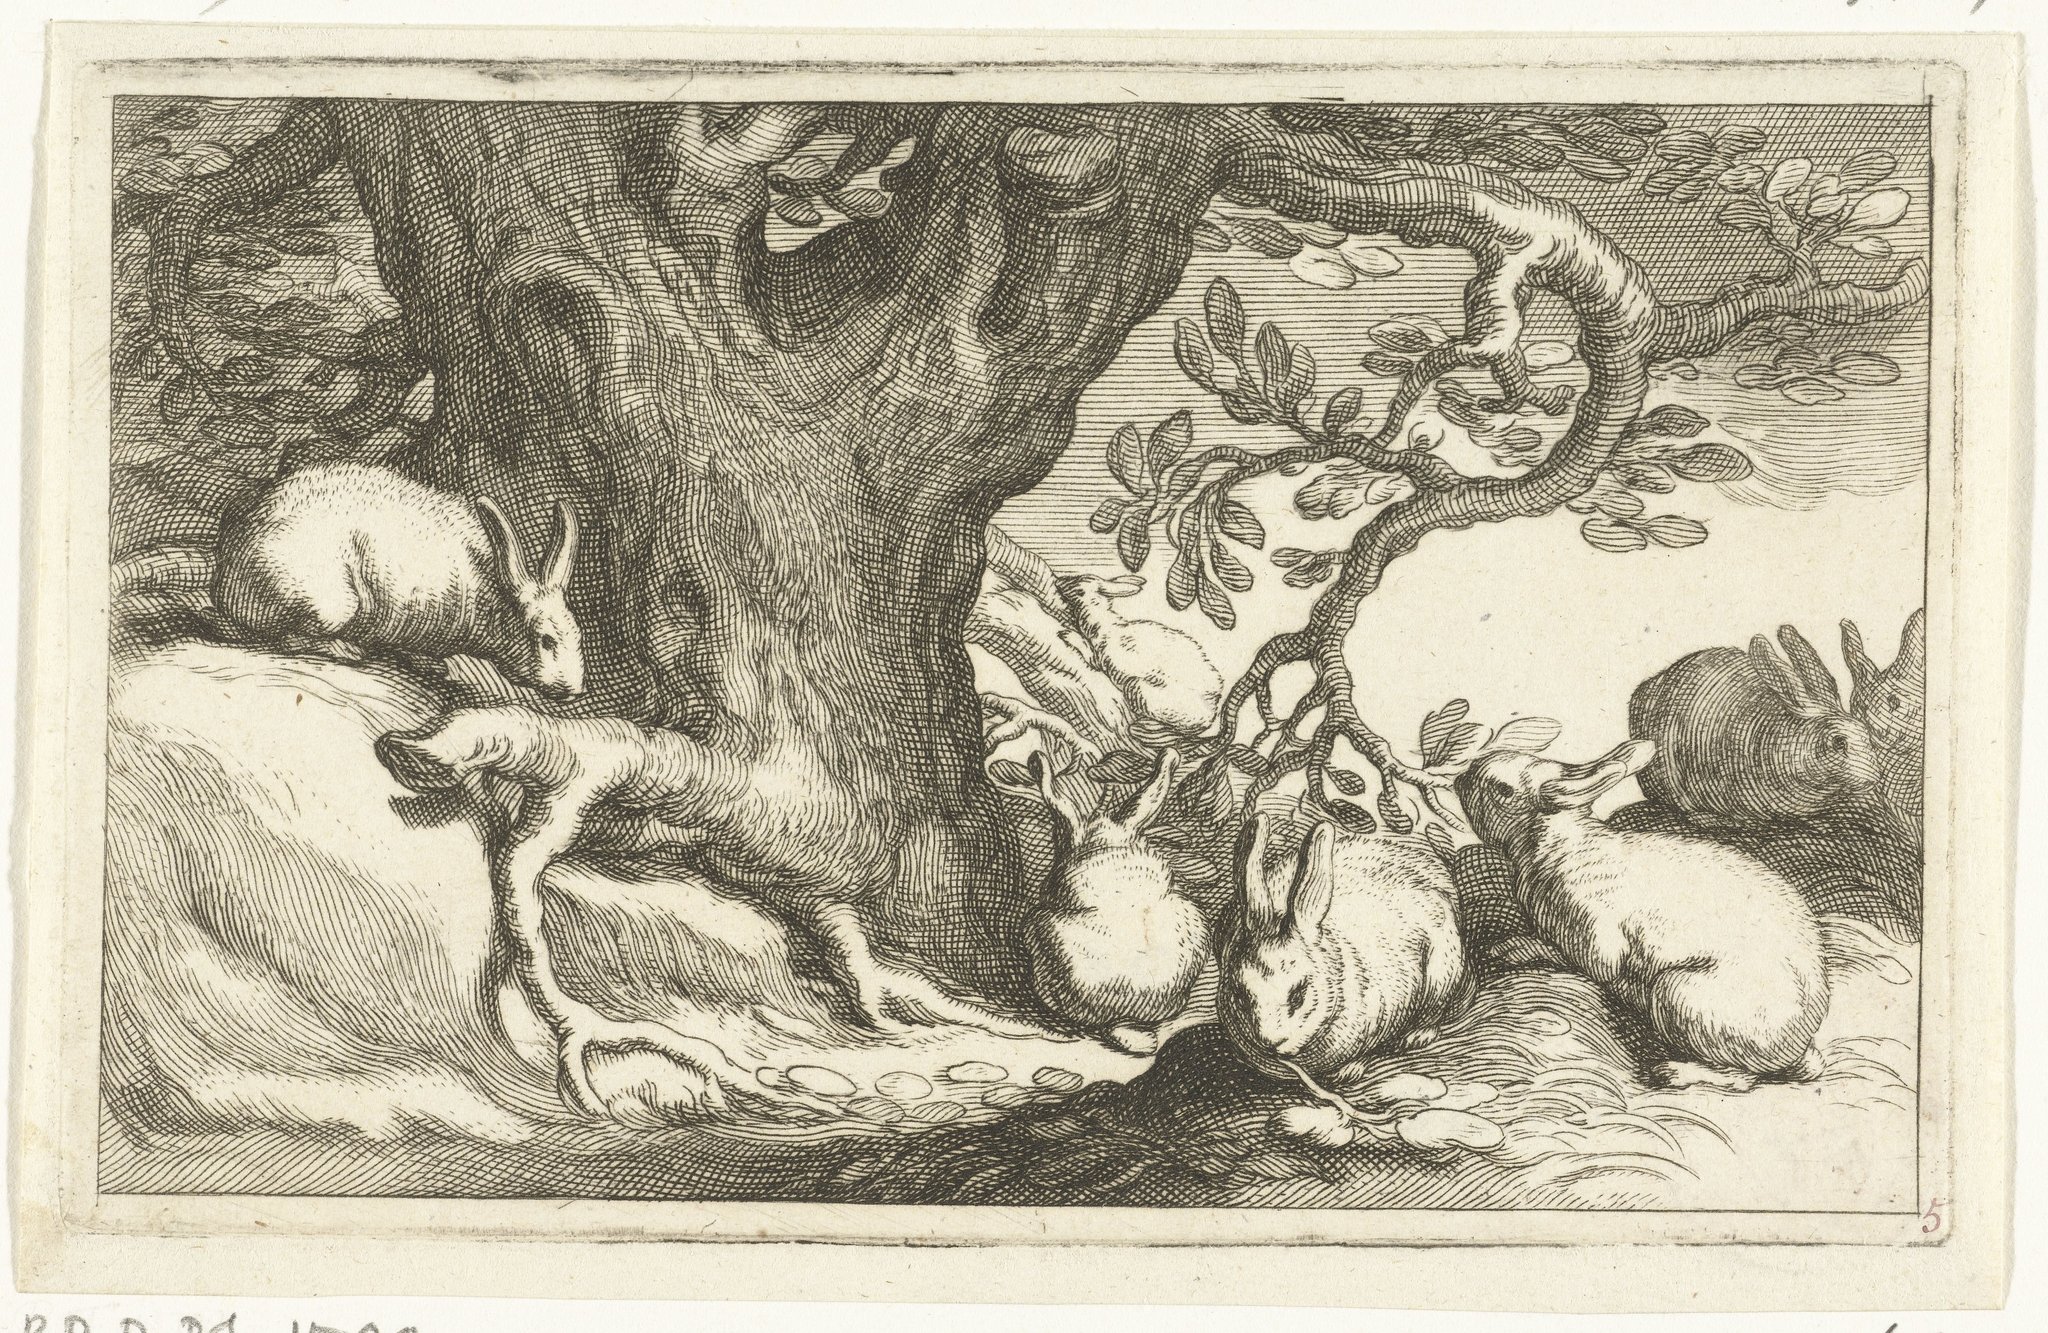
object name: print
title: Konijnen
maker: frederick bloemaert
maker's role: print maker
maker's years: 1614-1669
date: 1635-1670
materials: paper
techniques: engraving, etching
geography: utrecht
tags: rodents: hare, rodents: rabbit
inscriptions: collector's mark: Lugt 240, number: ‘5’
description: Een stel konijnen zit aan de voeten van een boom. Prent uit een serie van 14 prenten met verschillende inheemse dieren.